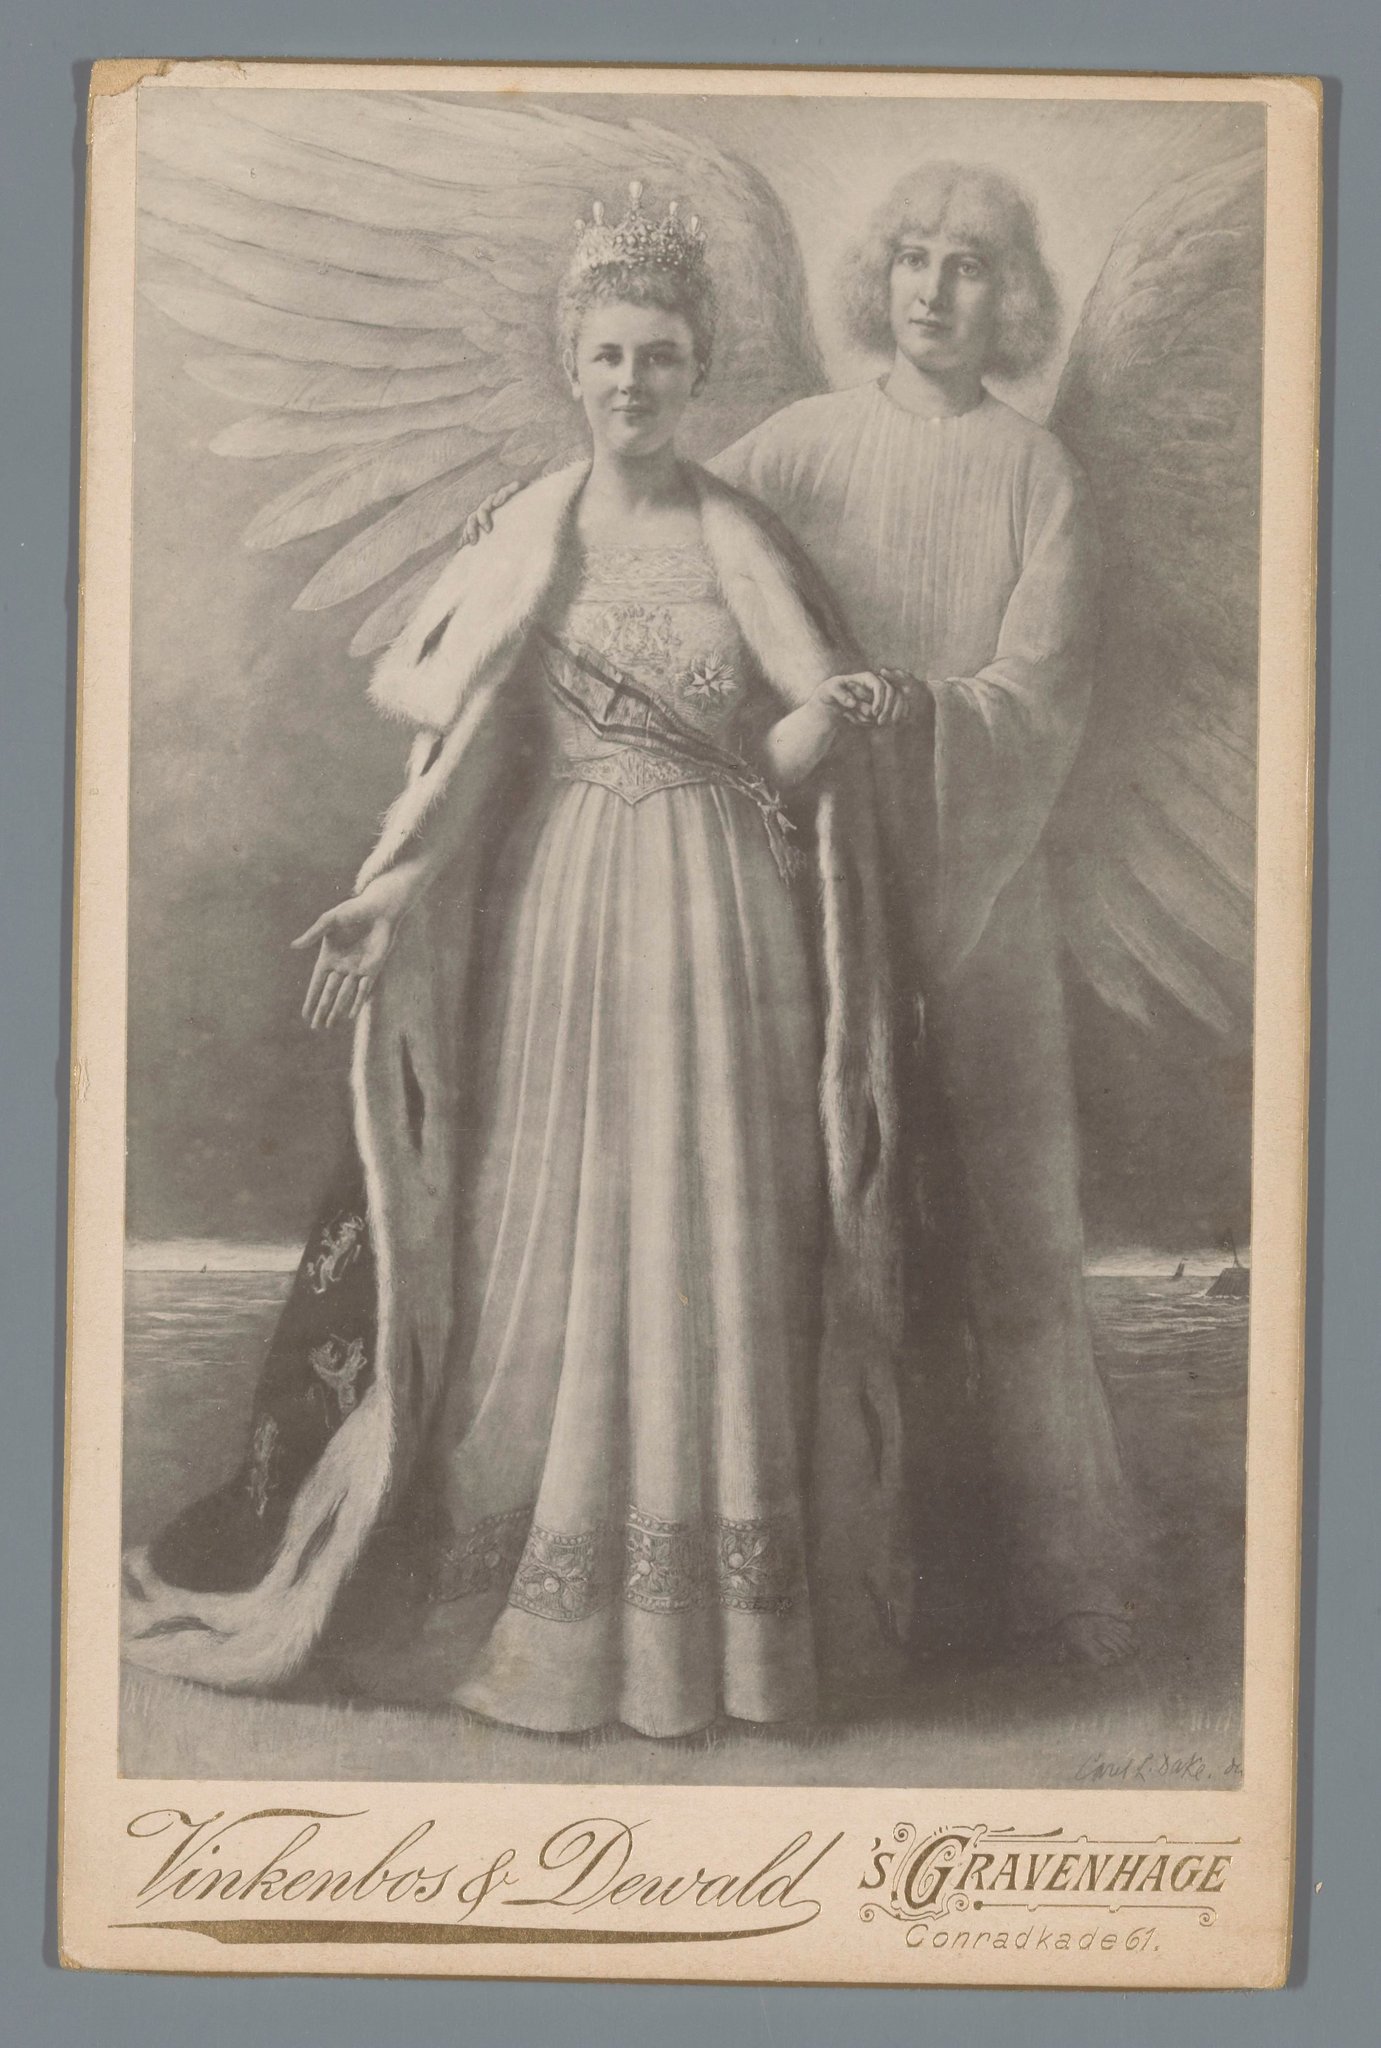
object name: cabinet photograph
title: Fotoreproductie van een tekening van koningin Wilhelmina gepresenteerd door een engel naar Carel Dake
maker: carel lodewijk dake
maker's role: draughtsman, painter, print maker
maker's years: 1857-1918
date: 1898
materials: cardboard, photographic support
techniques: platinum process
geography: the hague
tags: print maker, wilhelmina of the netherlands, queen, angels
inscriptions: number: ‘60’, inscription: ‘Firma/ Vinkenbos & Dewald/ 'S GRAVENHAGE/ Conradkade 61./ Telefoon 496.’